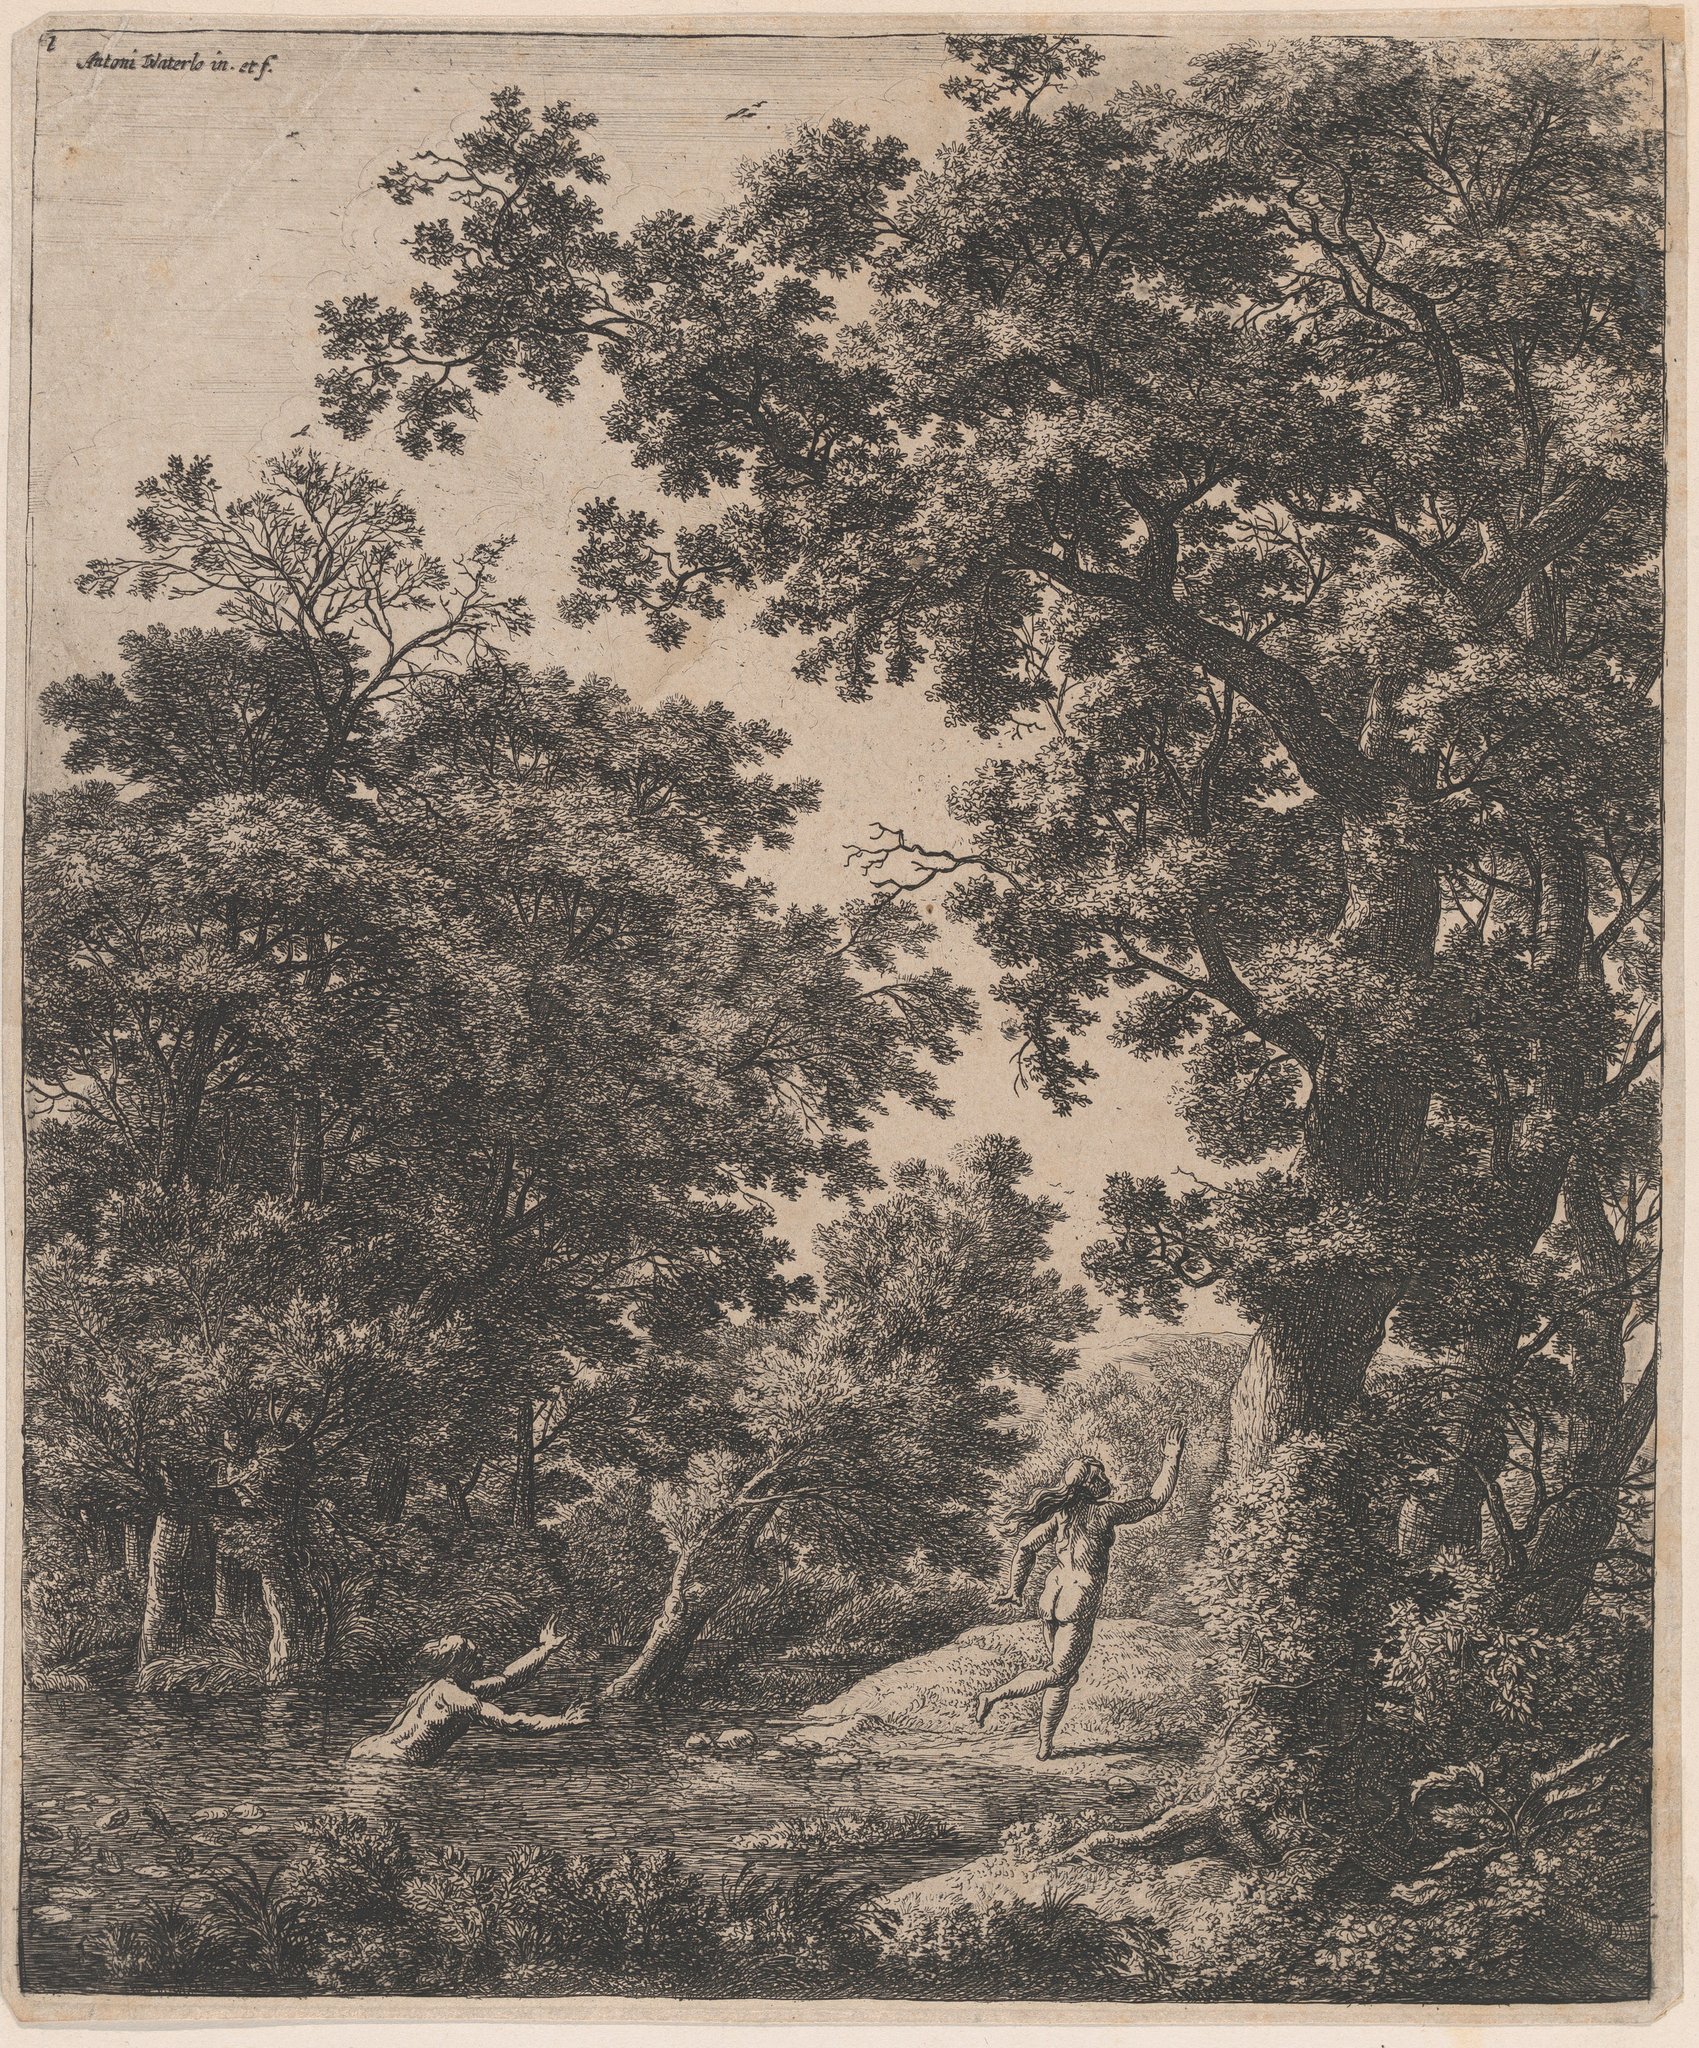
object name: print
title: Alpheus and Arethusa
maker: anthonie waterloo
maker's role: artist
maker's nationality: dutch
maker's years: 1609-1690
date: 1601-1700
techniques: etching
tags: female nudes,landscapes